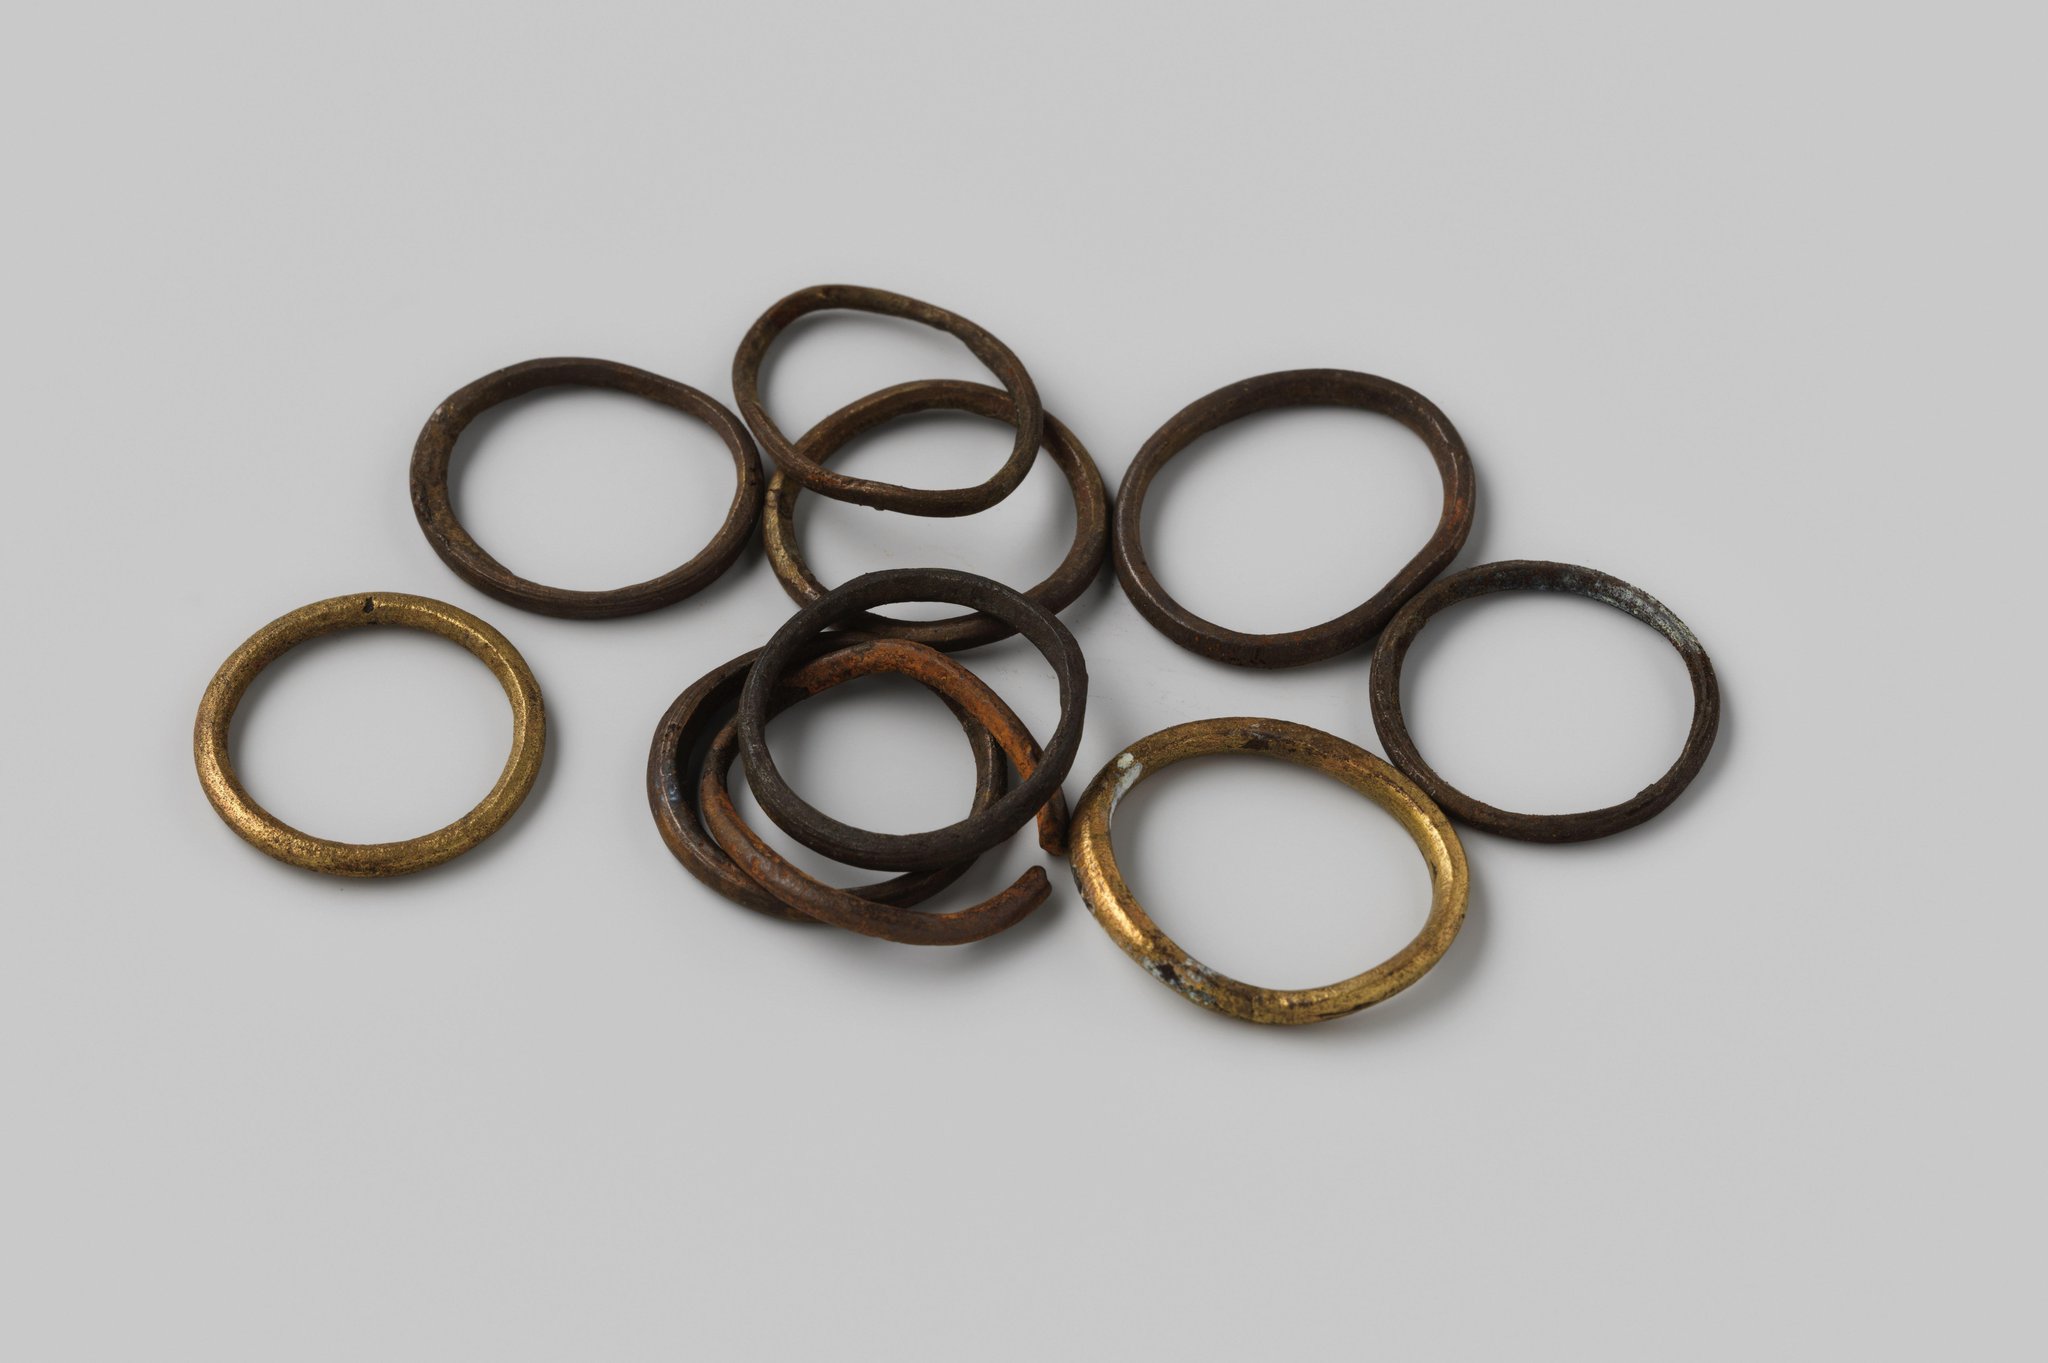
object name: fragment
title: Ringvormige fragmenten uit het wrak van de Oost-Indiëvaarder Hollandia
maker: Anonymous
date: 1700-1743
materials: copper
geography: netherlands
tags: verenigde oostindische compagnie, hollandia (schip), annet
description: Varied parts or fragments, rings or ring-shaped fragments; id. 80H946.